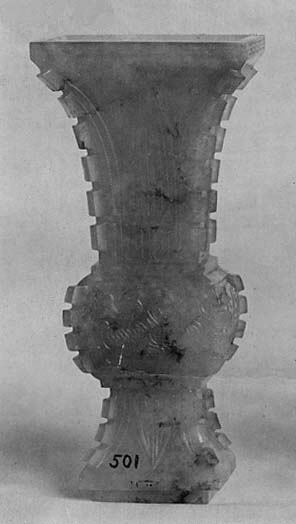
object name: vase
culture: chinese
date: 1736-1795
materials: gemstone, jade, wood